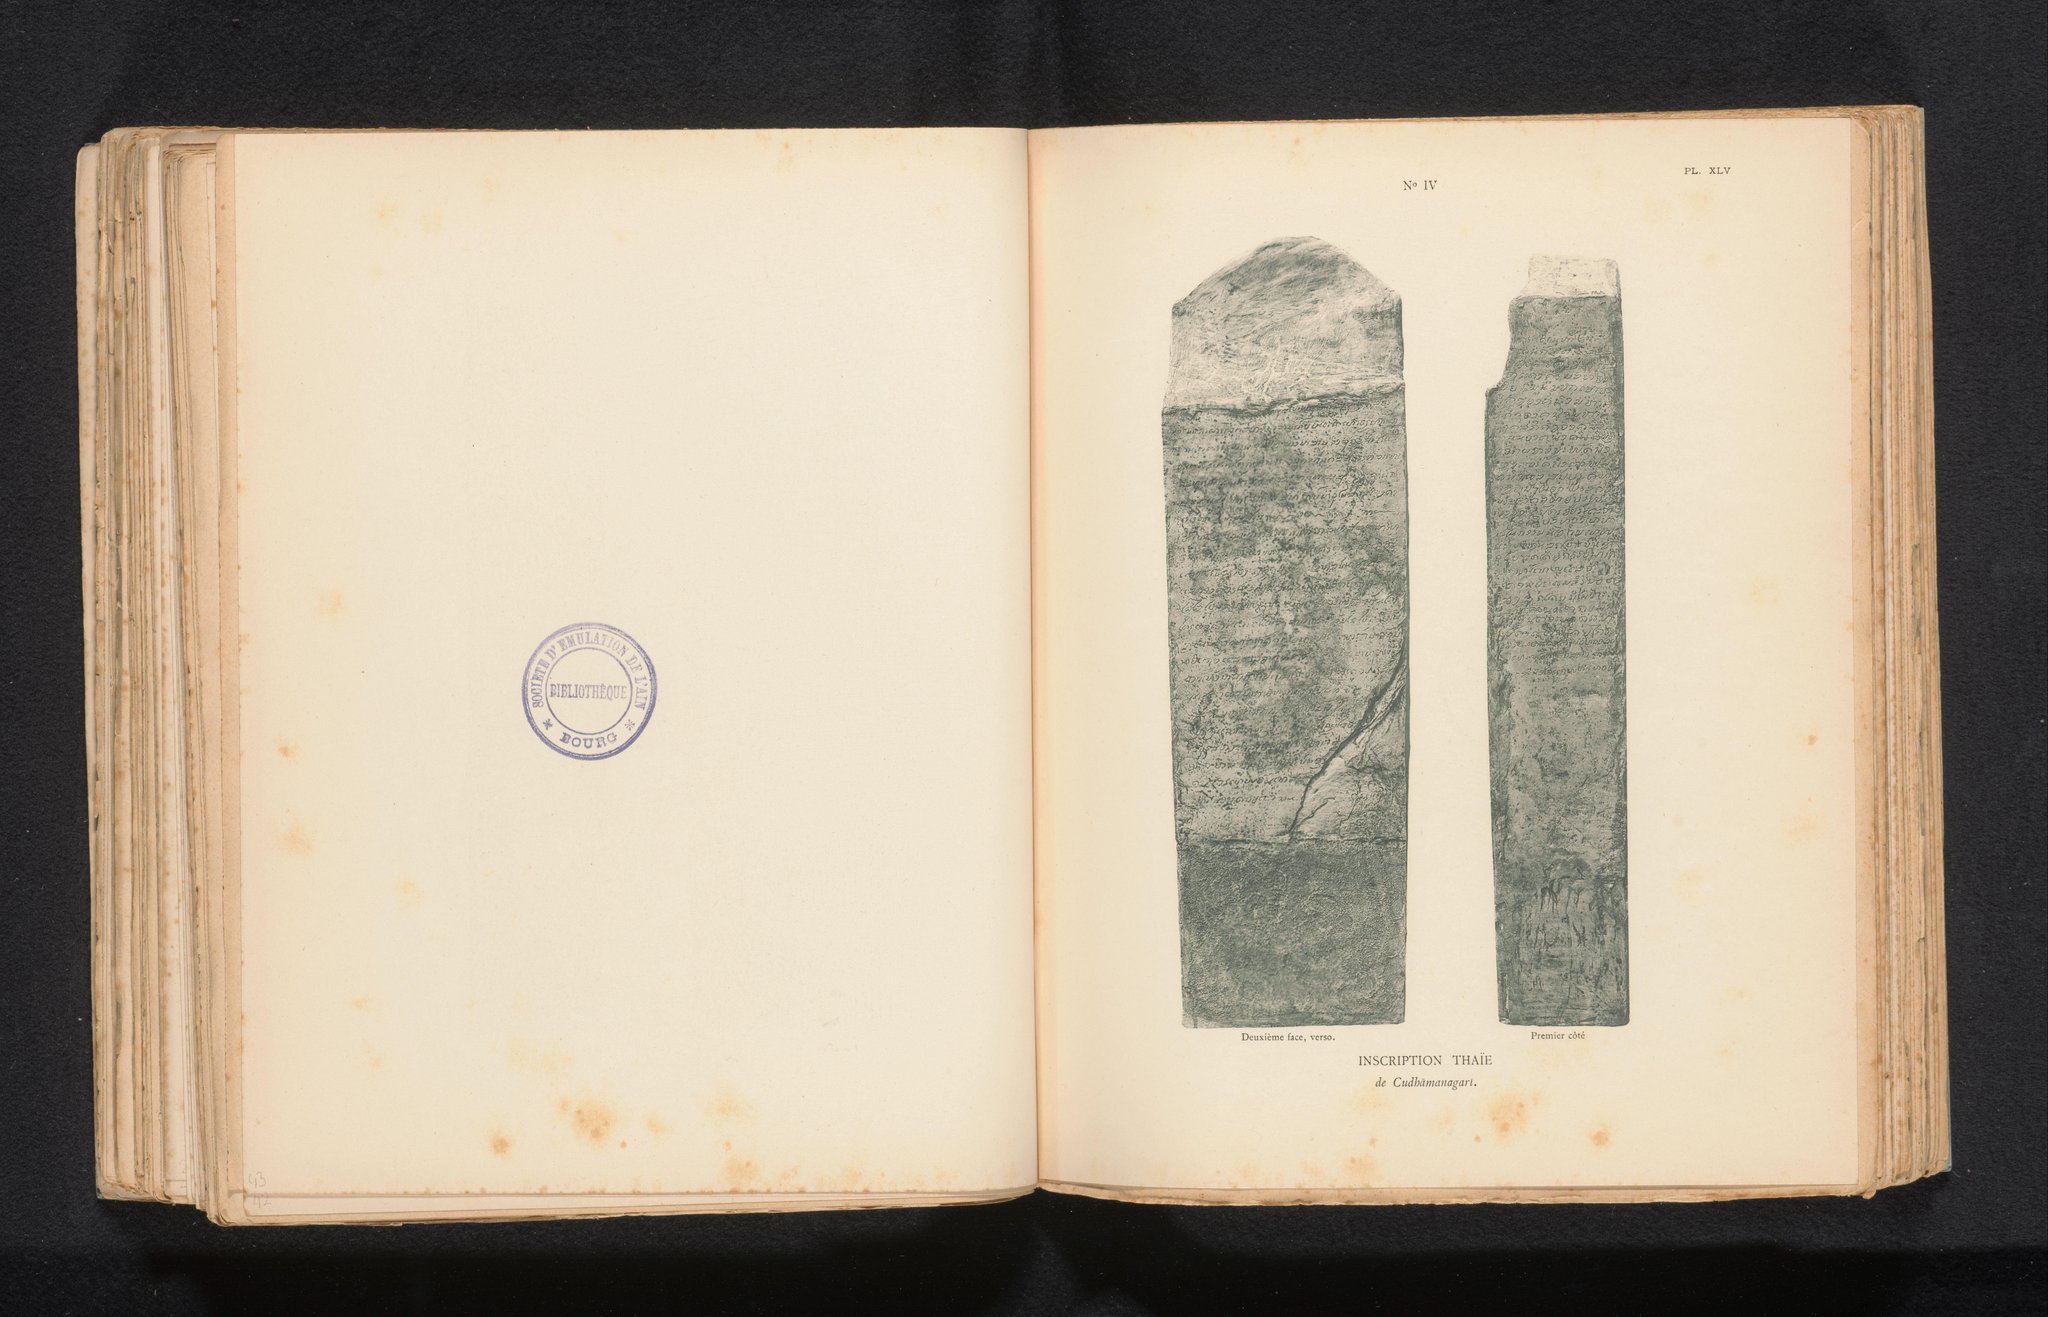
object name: photomechanical print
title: Inscription thaïe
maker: Anonymous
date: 1890-1895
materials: paper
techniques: photograph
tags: inscription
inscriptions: inscription: ‘de Cudhāmanagarī’, collector's mark: ‘Société d'Emulation de l'Ain/ Bourg/ Bibliothèque’, inscription: ‘No. IV/ Deuxième face, verso. Premiére côté’, inscription: ‘Pl. XLV’